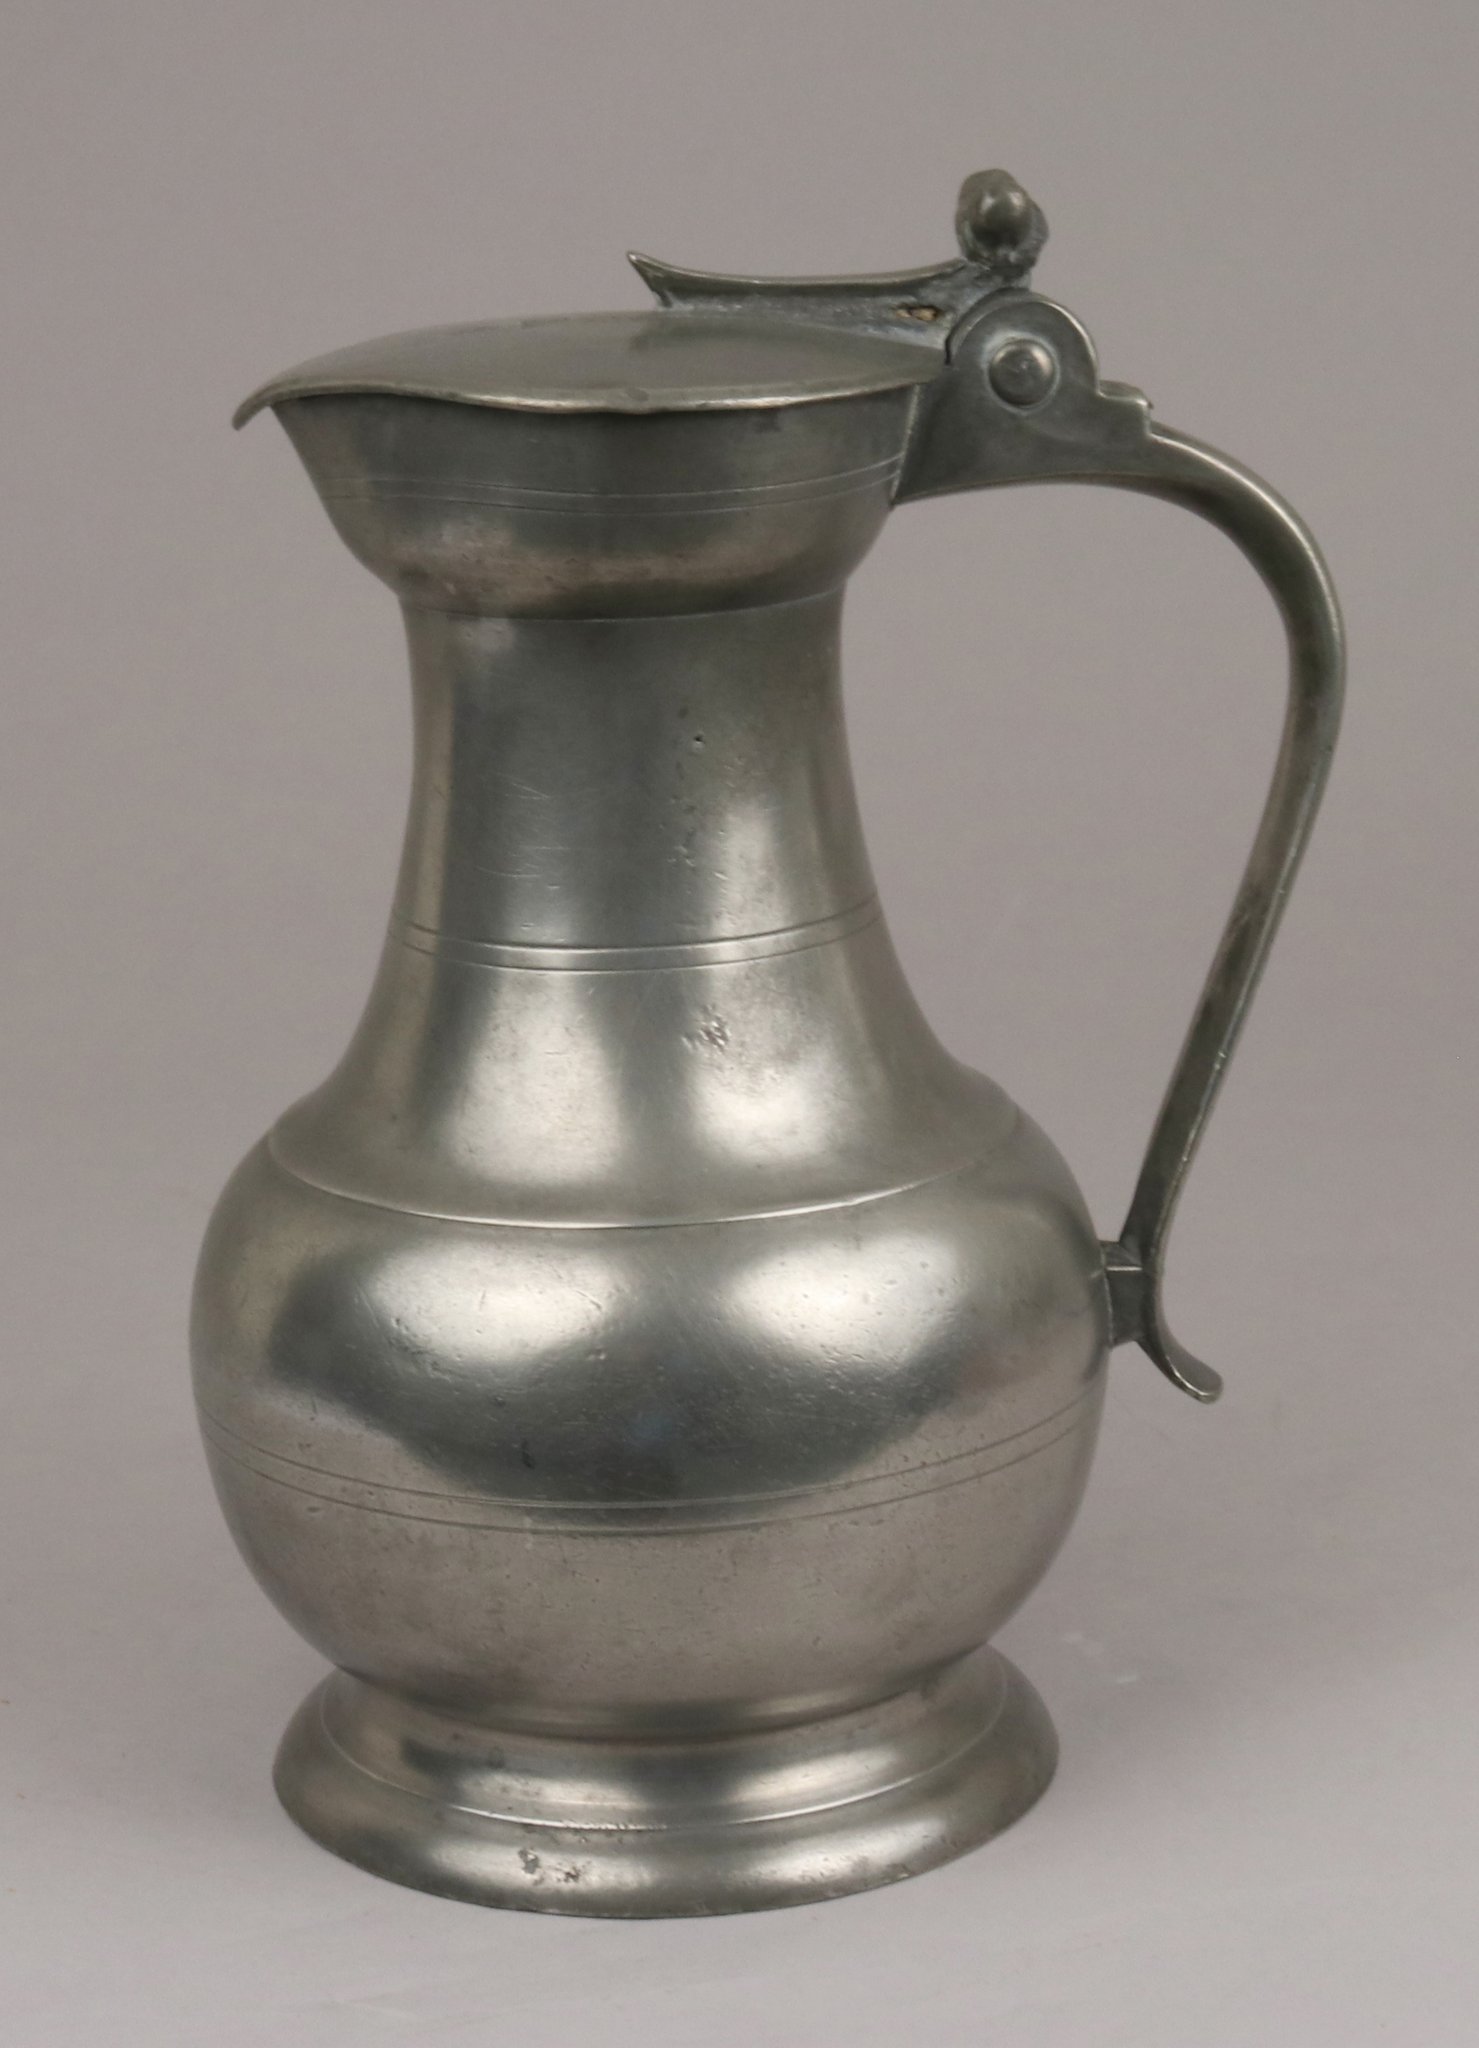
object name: pitcher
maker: pierre malmouche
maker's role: maker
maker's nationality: french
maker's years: 1747-1764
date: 1747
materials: pewter